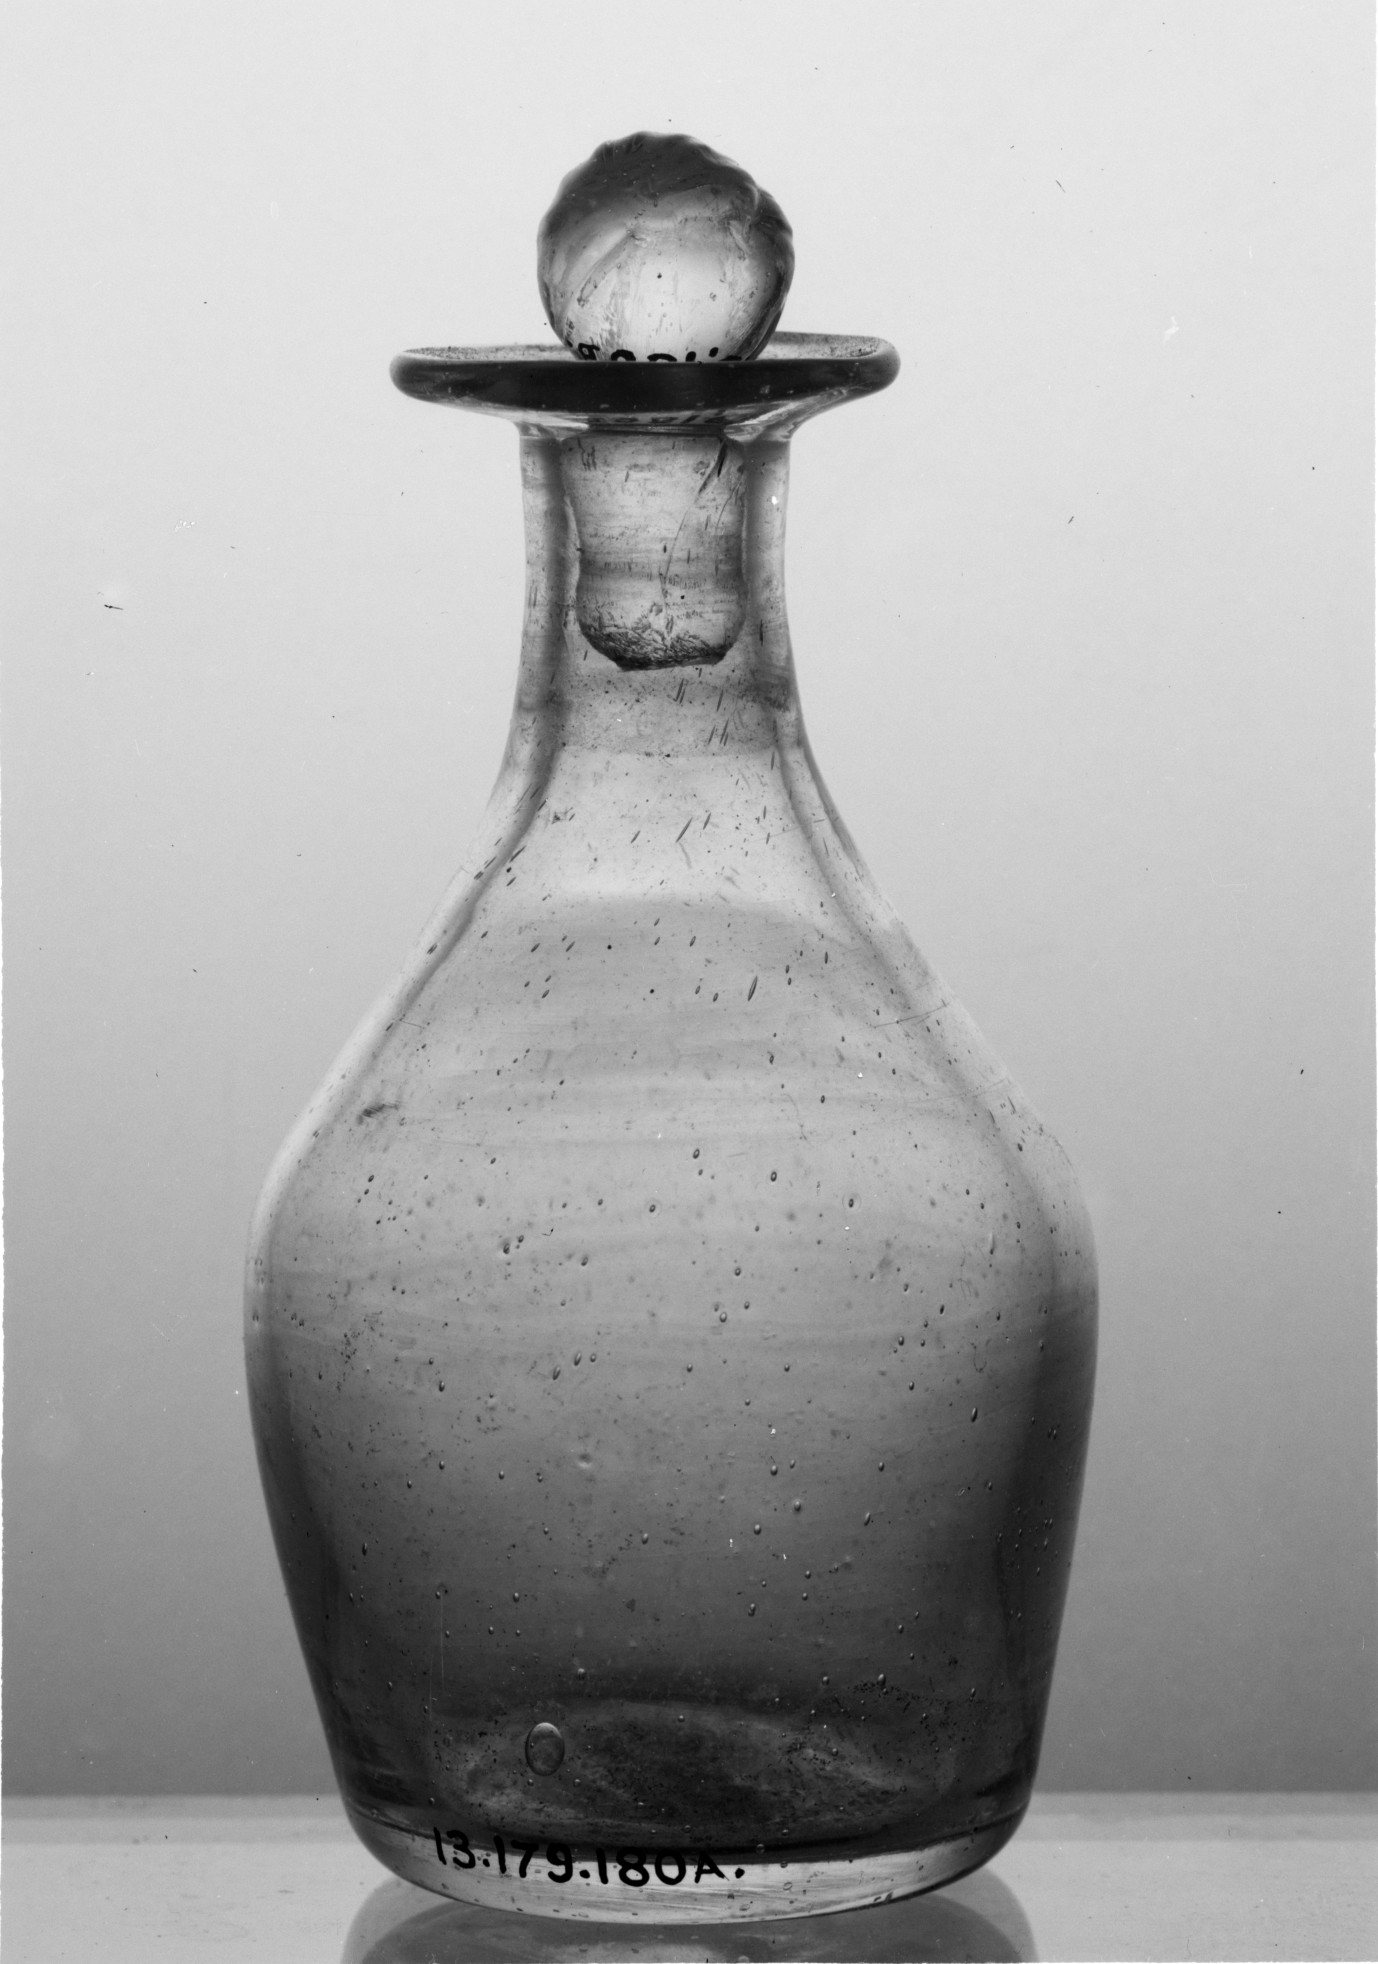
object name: decanter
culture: american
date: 1700-1900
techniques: glassblowing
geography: united states